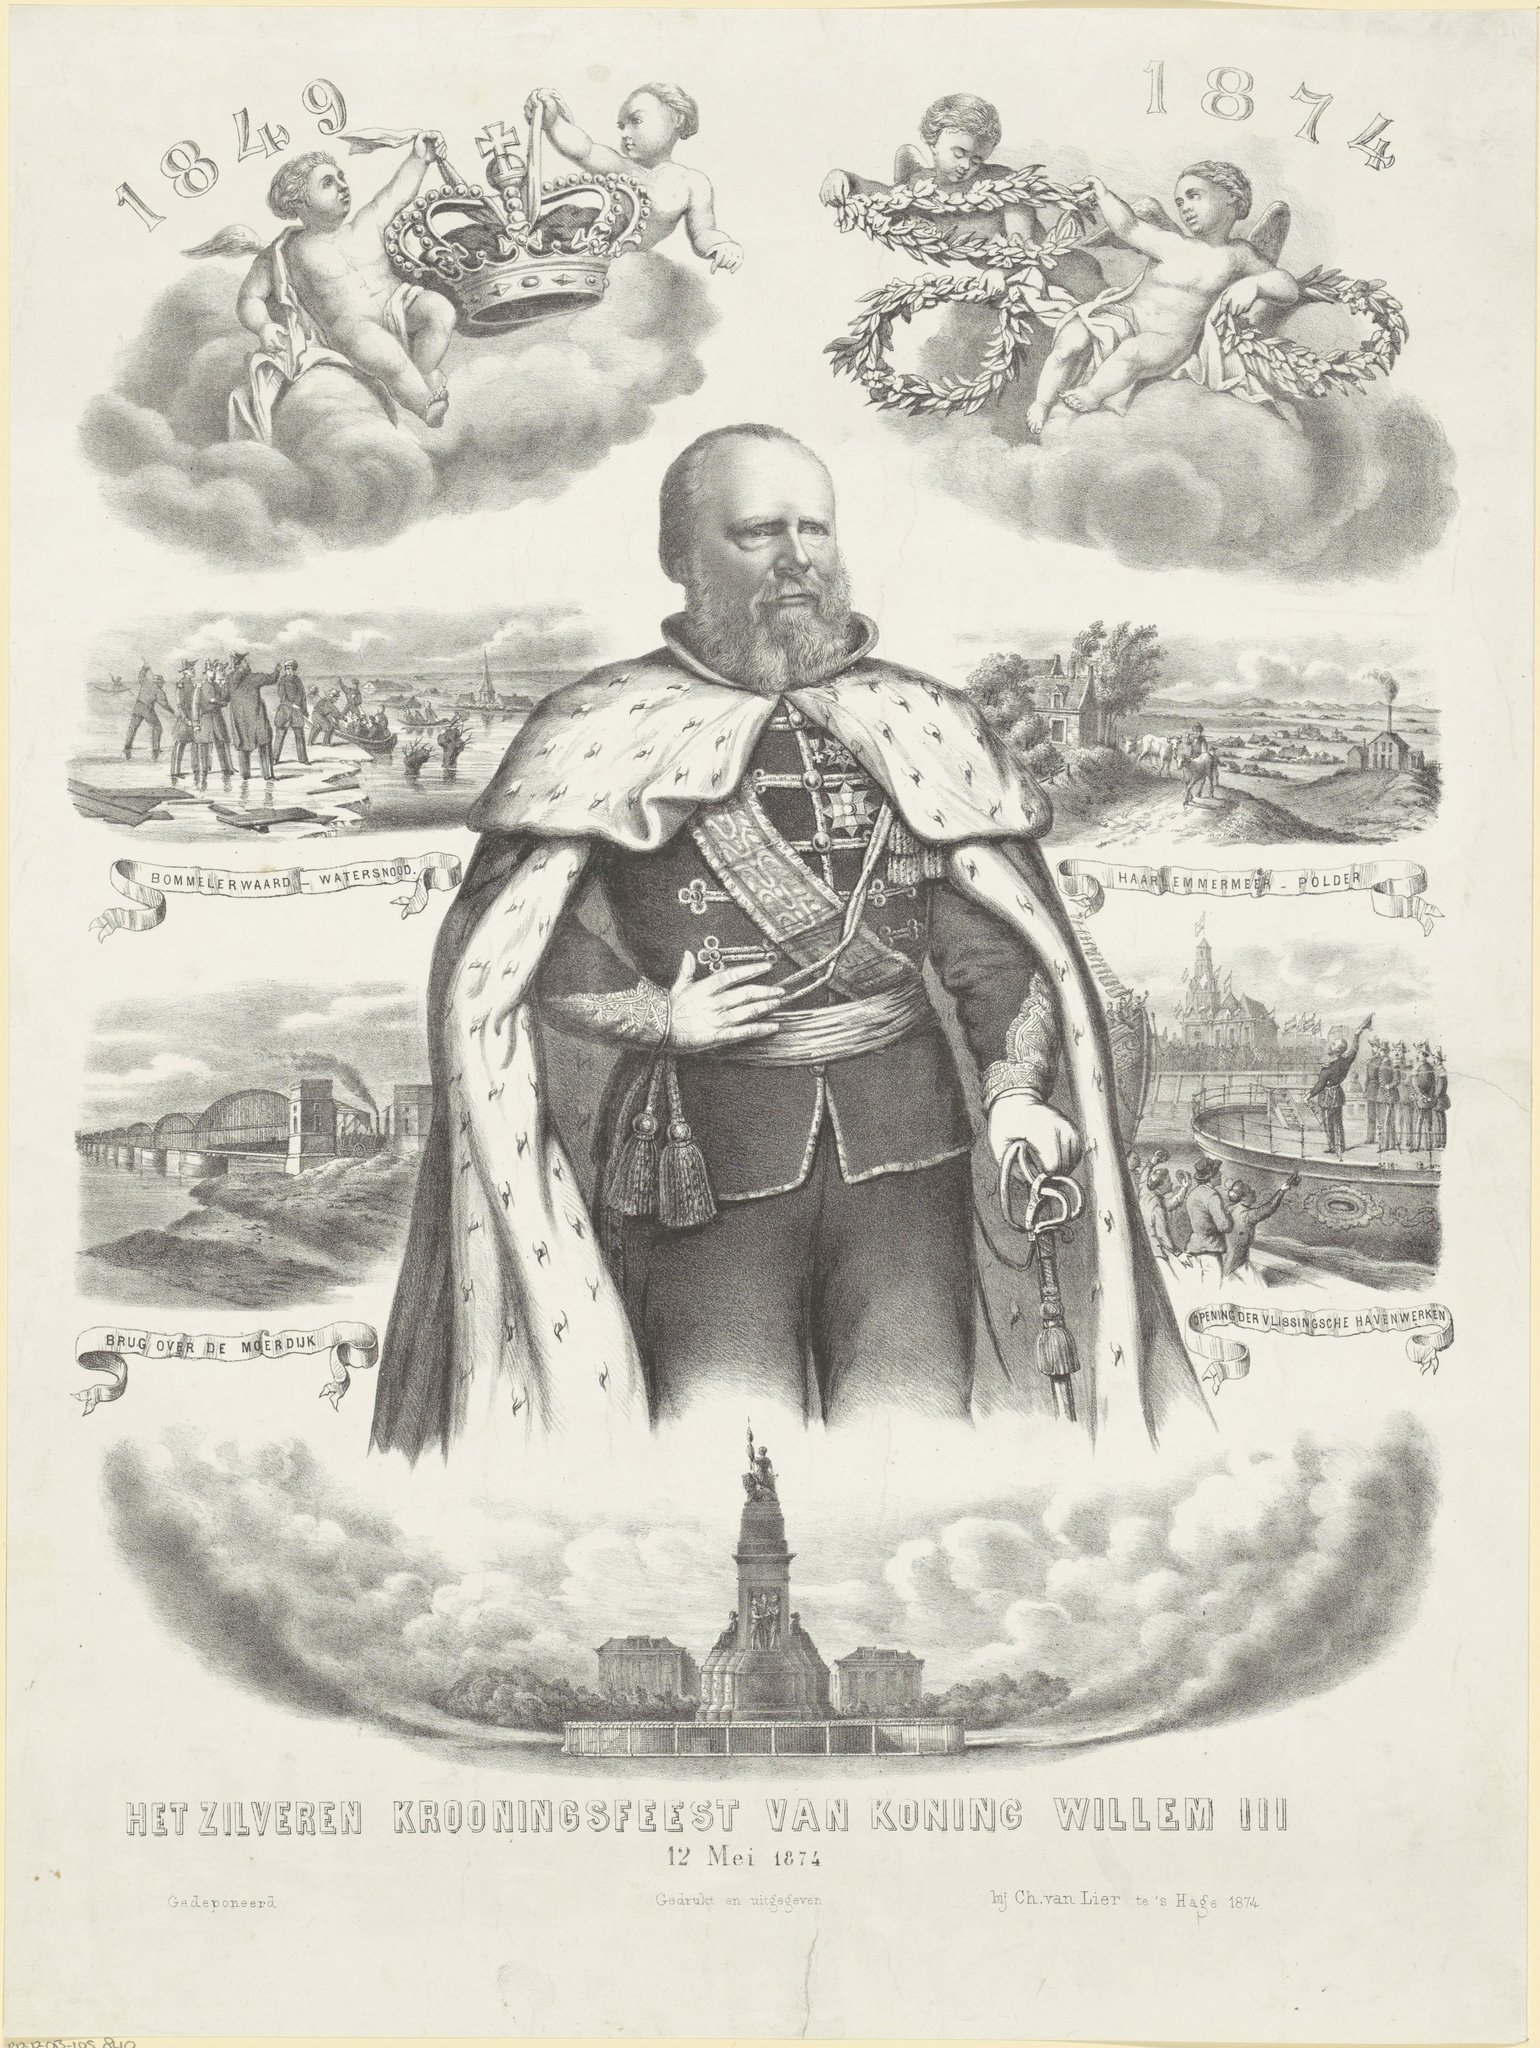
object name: print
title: 25-jarig regeringsjubileum van Willem III, koning der Nederlanden, 1874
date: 1874-1876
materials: paper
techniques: lithograph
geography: the hague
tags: willem iii (koning der nederlanden)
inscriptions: octrooivermelding, gedrukt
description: 25-jarig regeringsjubileum van Willem III, 1874. In het midden een portret van Willem III met een hermelijnen mantel. Rondom taferelen uit zijn regering tot 1874. Linksboven twee putti met een kroon en rechtsboven twee putti met lauwerkransen. In de bovenmarge de jaartallen '1849-1874'. In de ondermarge twee regels Nederlandse tekst.